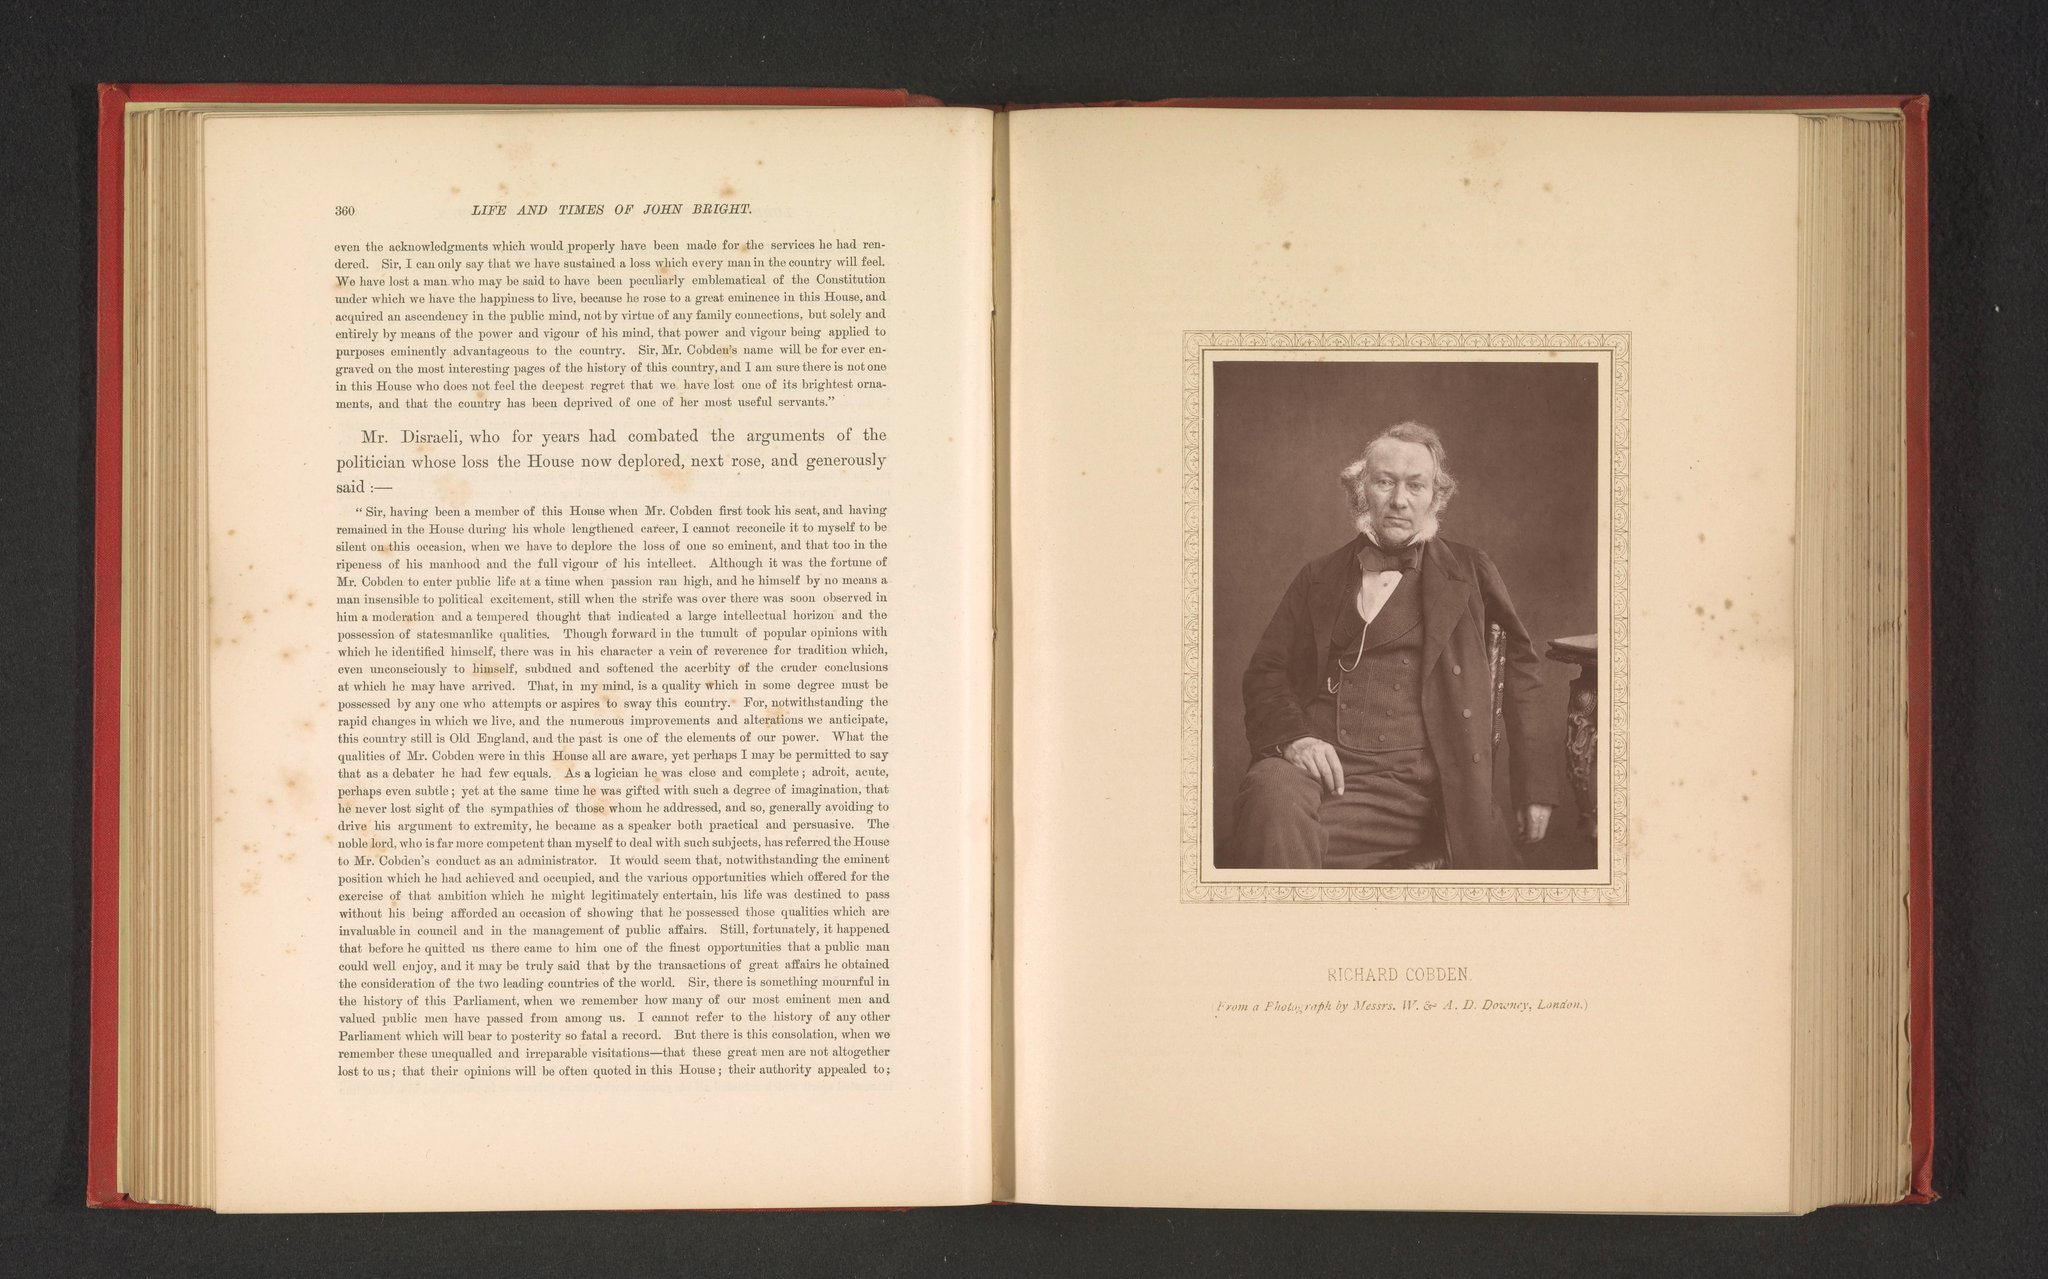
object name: page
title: Portret van Richard Cobden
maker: Anonymous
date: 1874-1884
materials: paper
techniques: woodburytype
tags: politician, manufacturer, official; civil servant; functionary (in general)